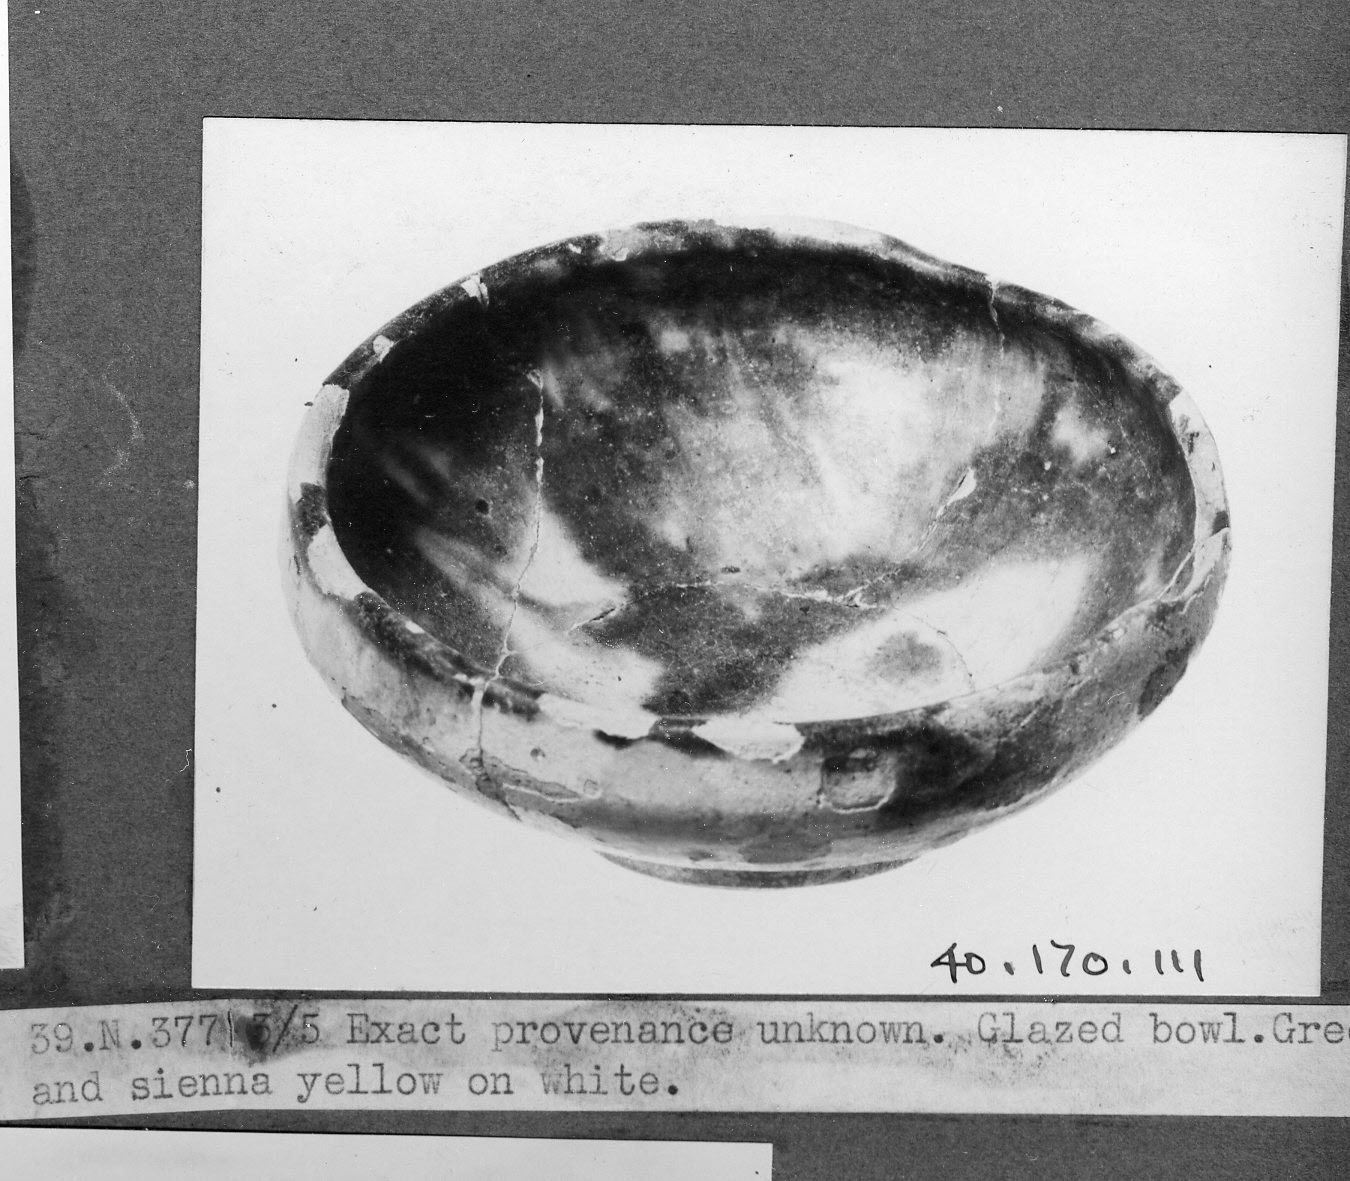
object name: bowl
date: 801-1000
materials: earthenware, glaze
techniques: polychrome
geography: iran